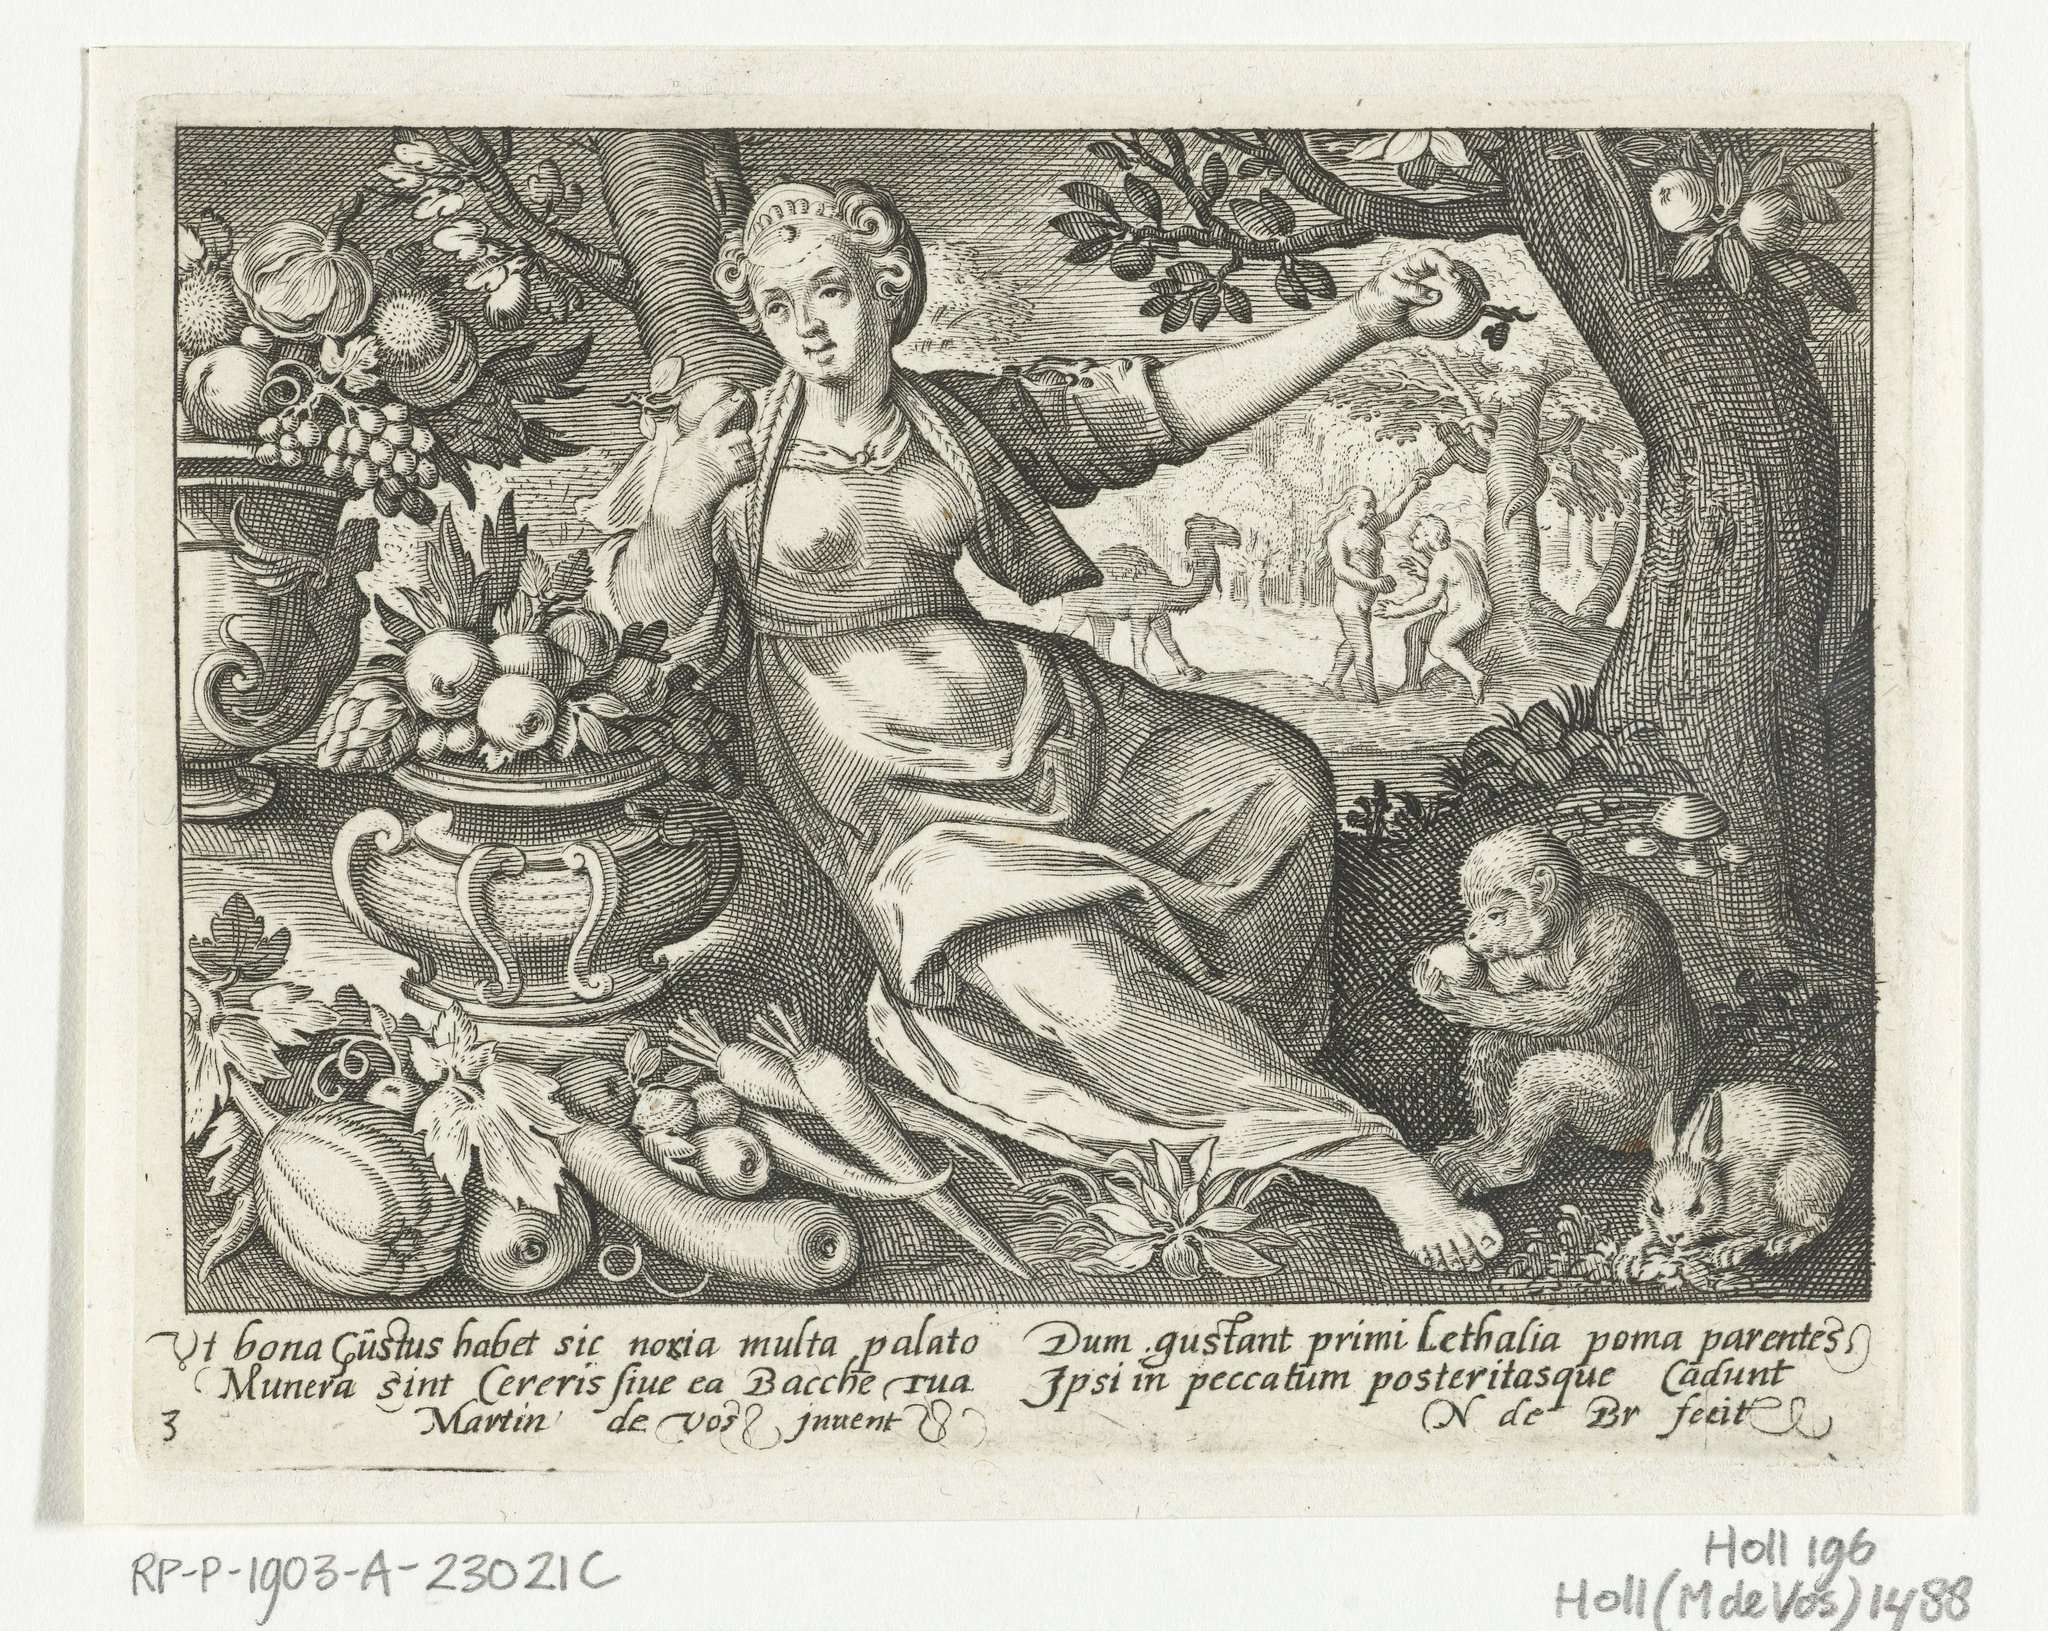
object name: print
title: Zintuig smaak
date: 1581-1656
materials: paper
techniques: engraving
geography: netherlands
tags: taste, tasting (one of the five senses), eve offers the fruit to adam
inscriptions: collector's mark: Lugt 2228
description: Vrouw als personificatie van zintuig smaak zittend in landschap met vazen vol fruit en groenten, zij eet van een appel terwijl een aap en konijn ook eten. Op de achtergrond is de zondeval van Adam en Eva weergegeven. In marge onder twee regels Latijn.